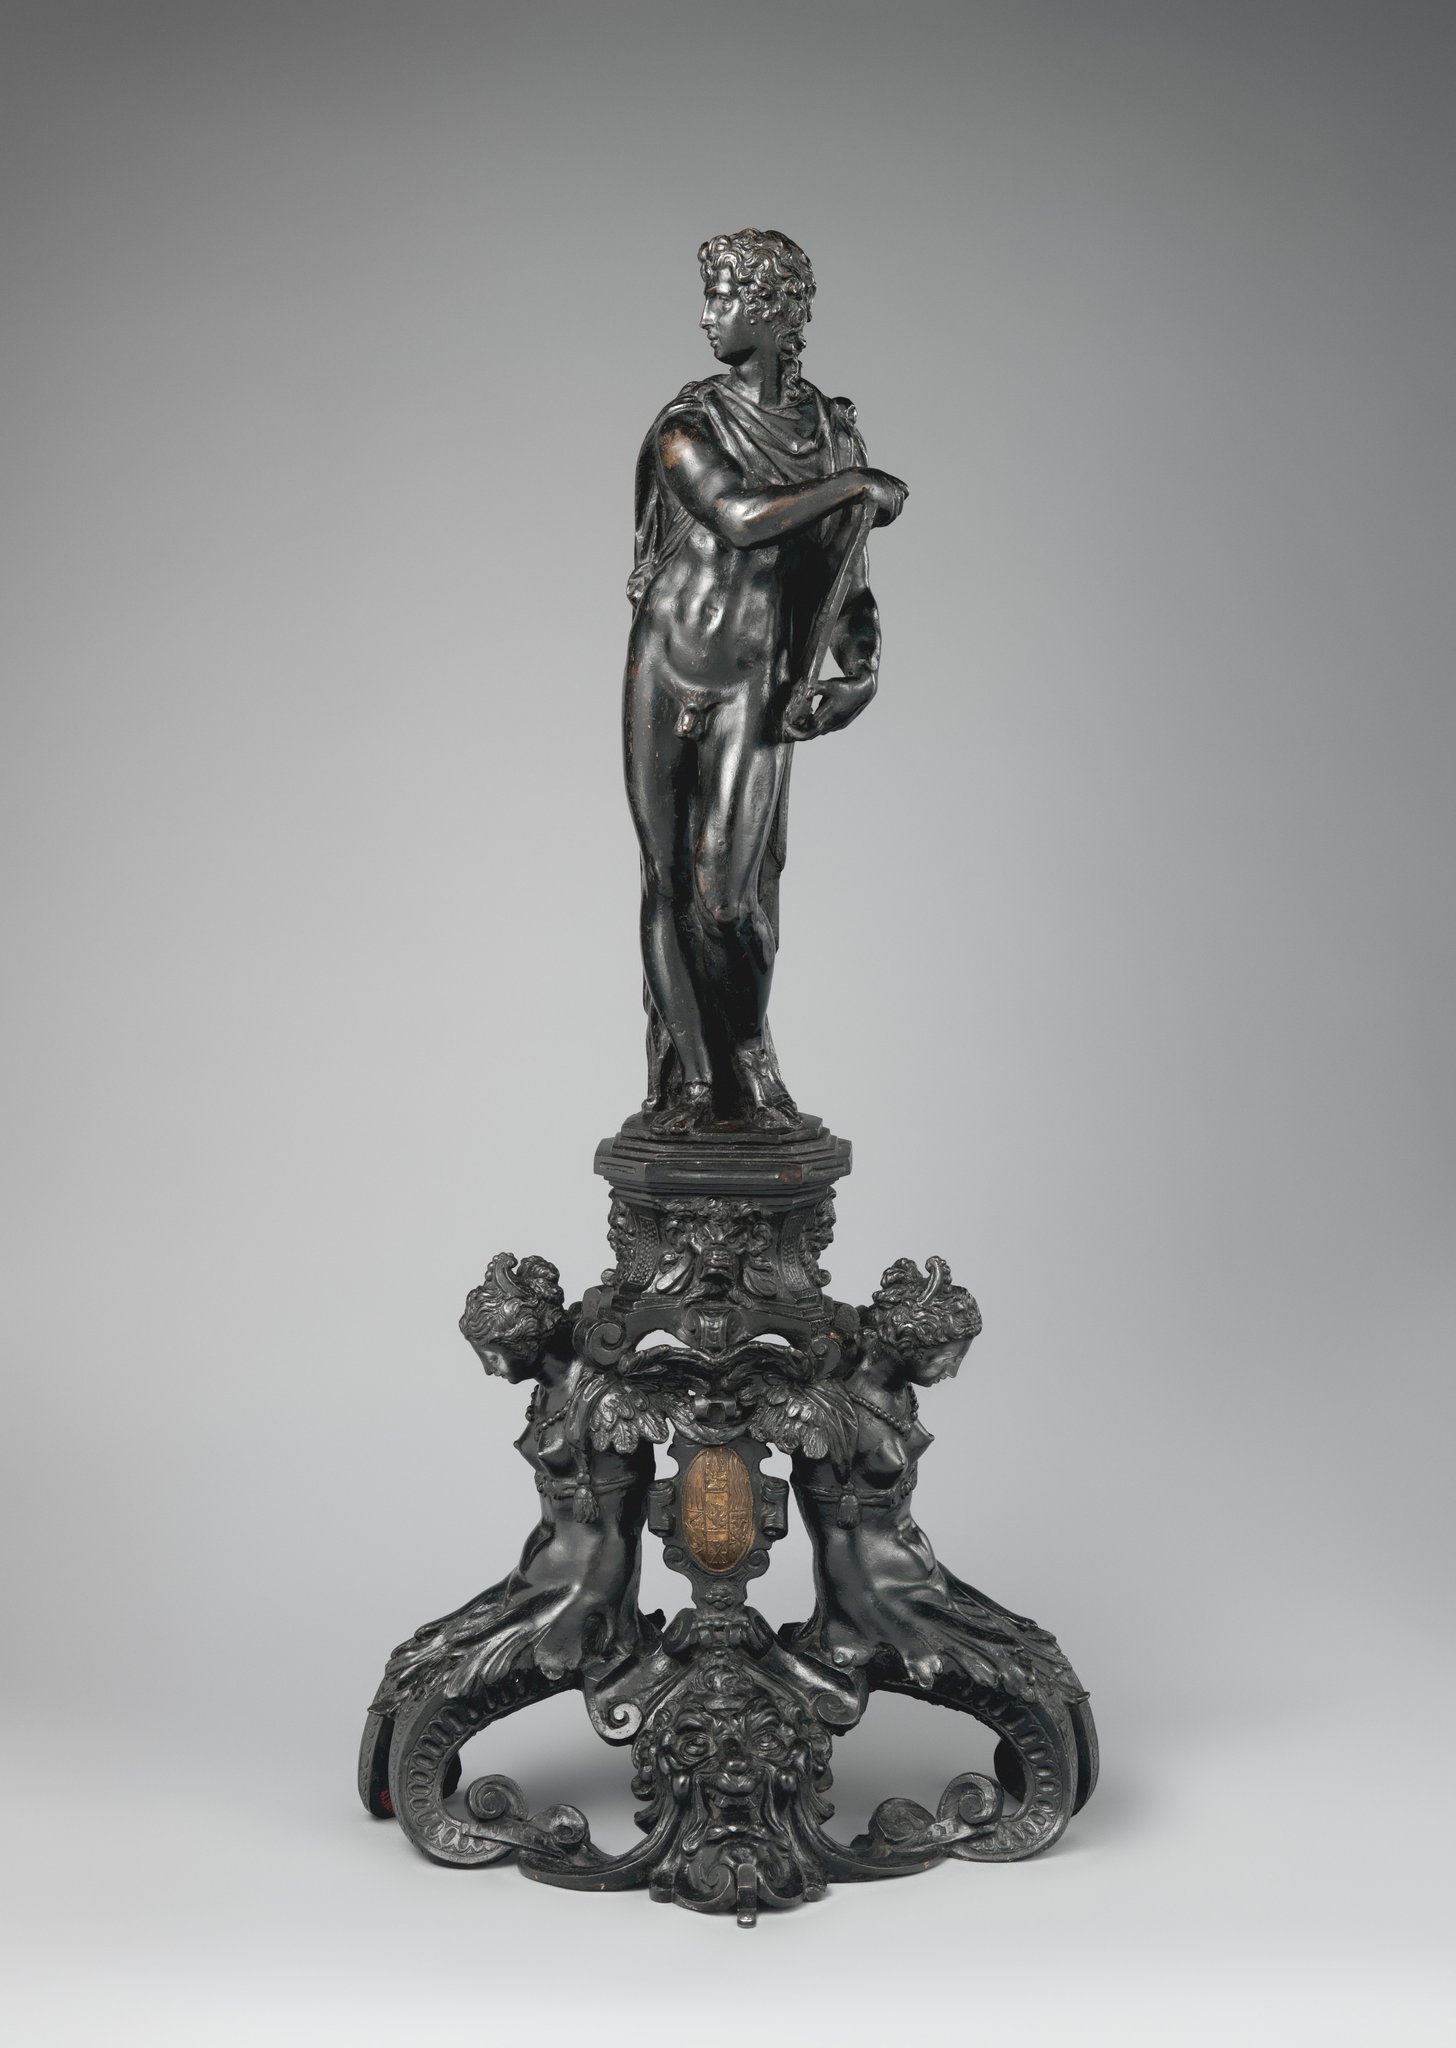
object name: andiron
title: Andiron with figure of Orpheus (one of a pair)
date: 1501-1600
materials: bronze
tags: orpheus